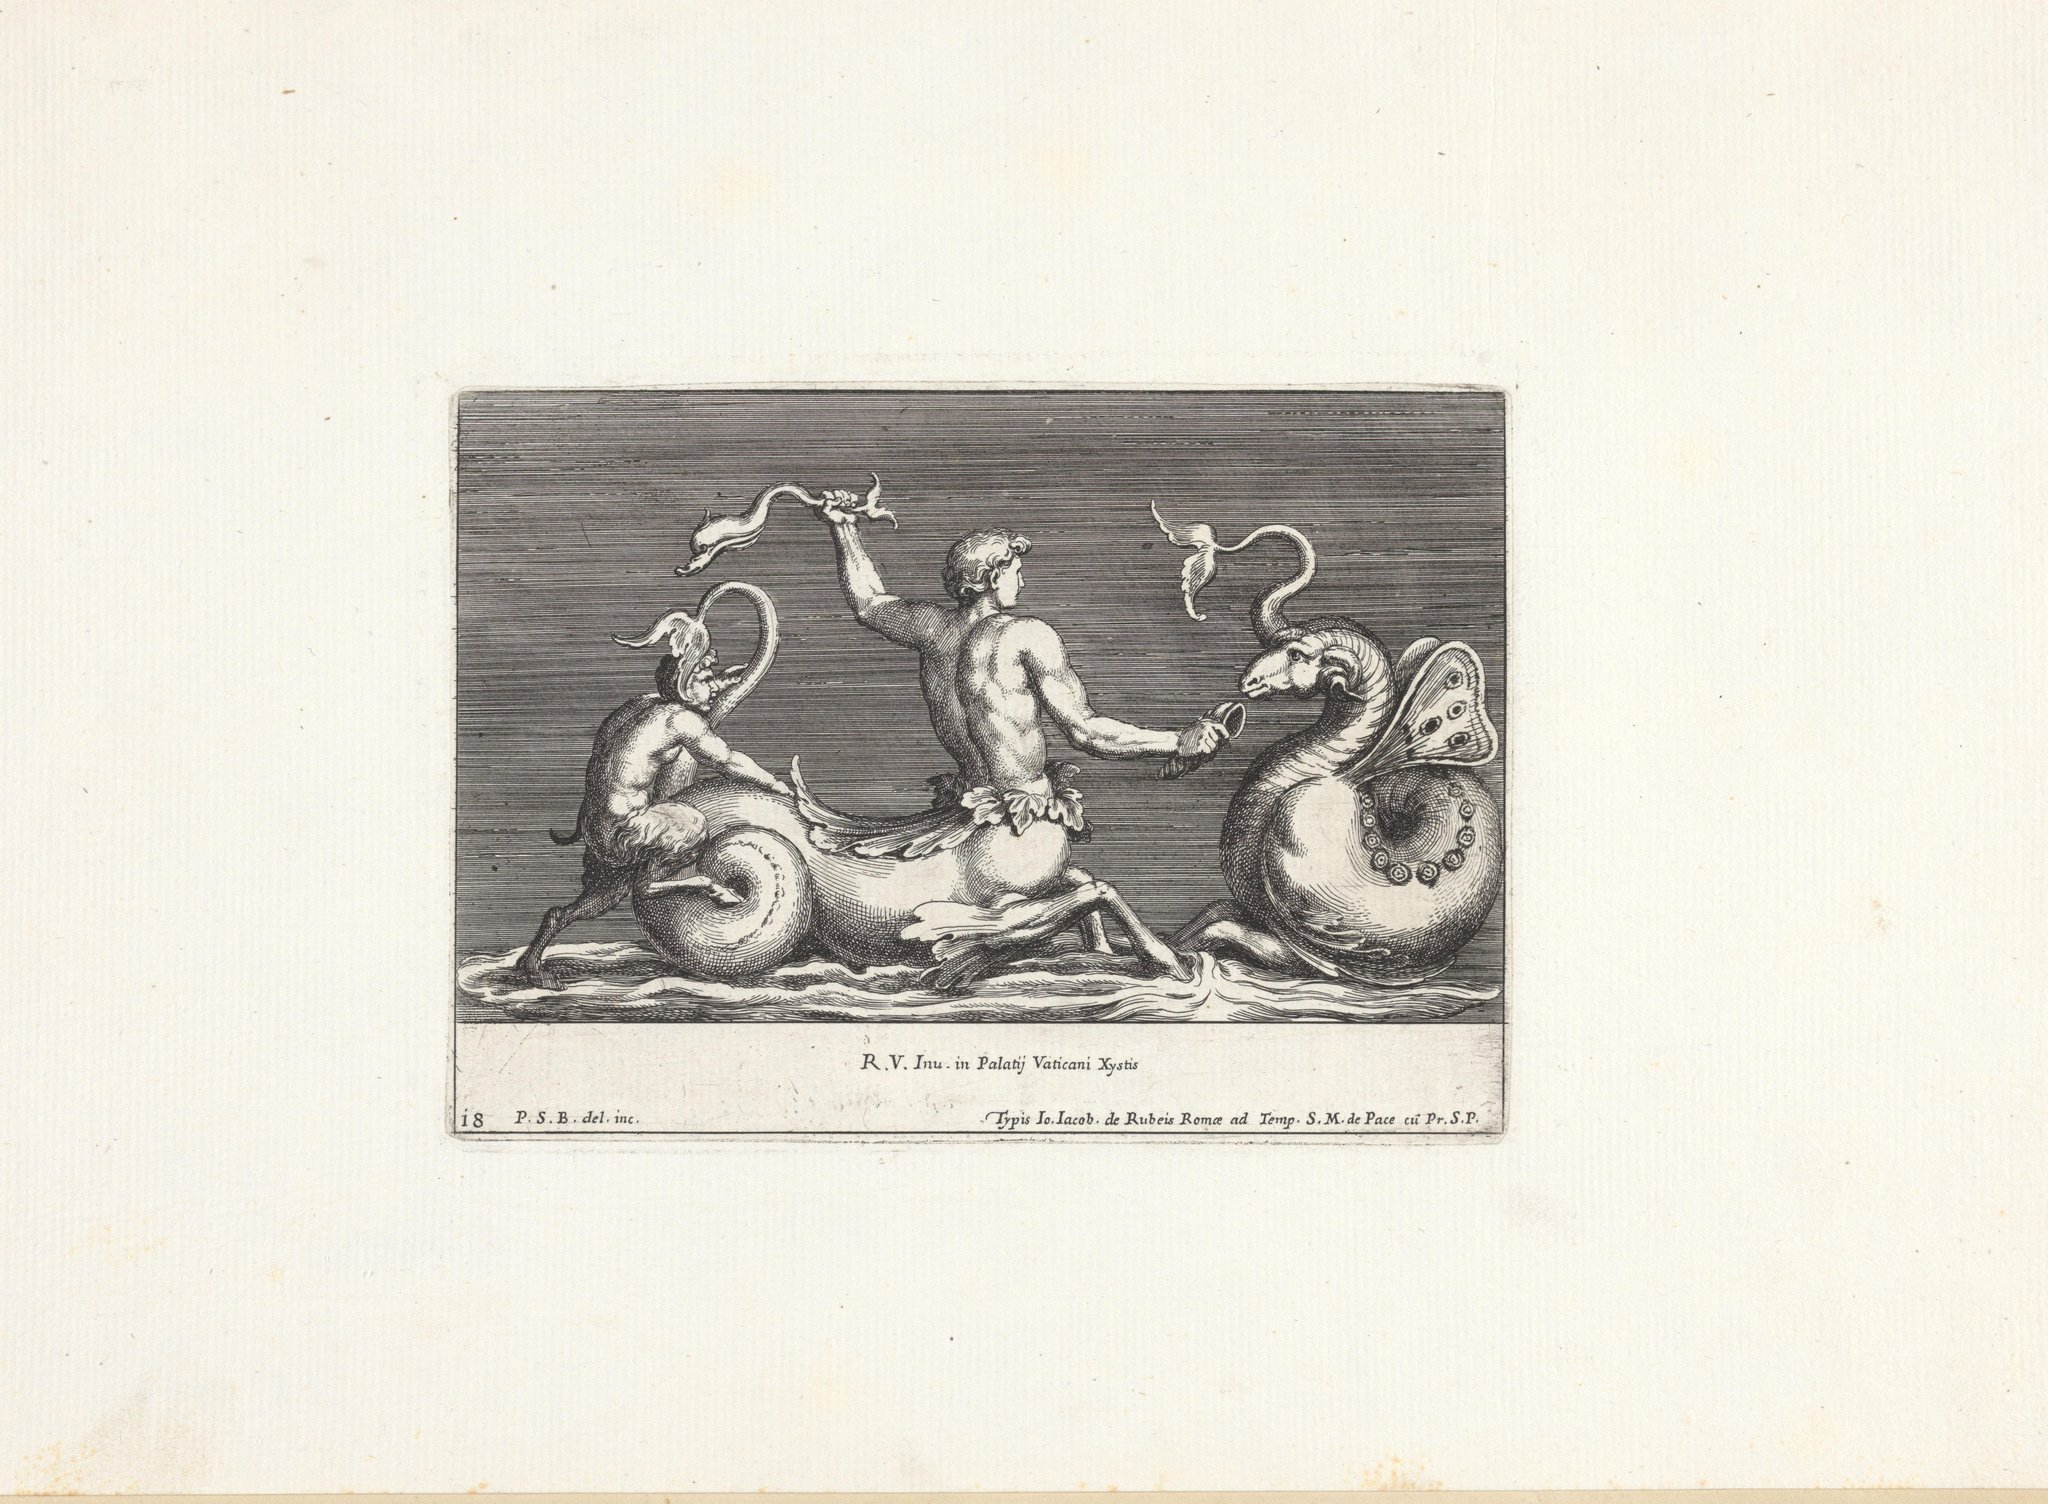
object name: print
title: Reliëfs in de Loggia van Rafaël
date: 1645-1700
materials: paper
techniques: engraving, etching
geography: vatican city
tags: triton(s), monsters of the sea, satyr(s) (in general)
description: Prent uit een reeks naar de gipsen reliëfs door Rafaël en uitgevoerd door zijn assistenten in de Vaticaanse Loggia.